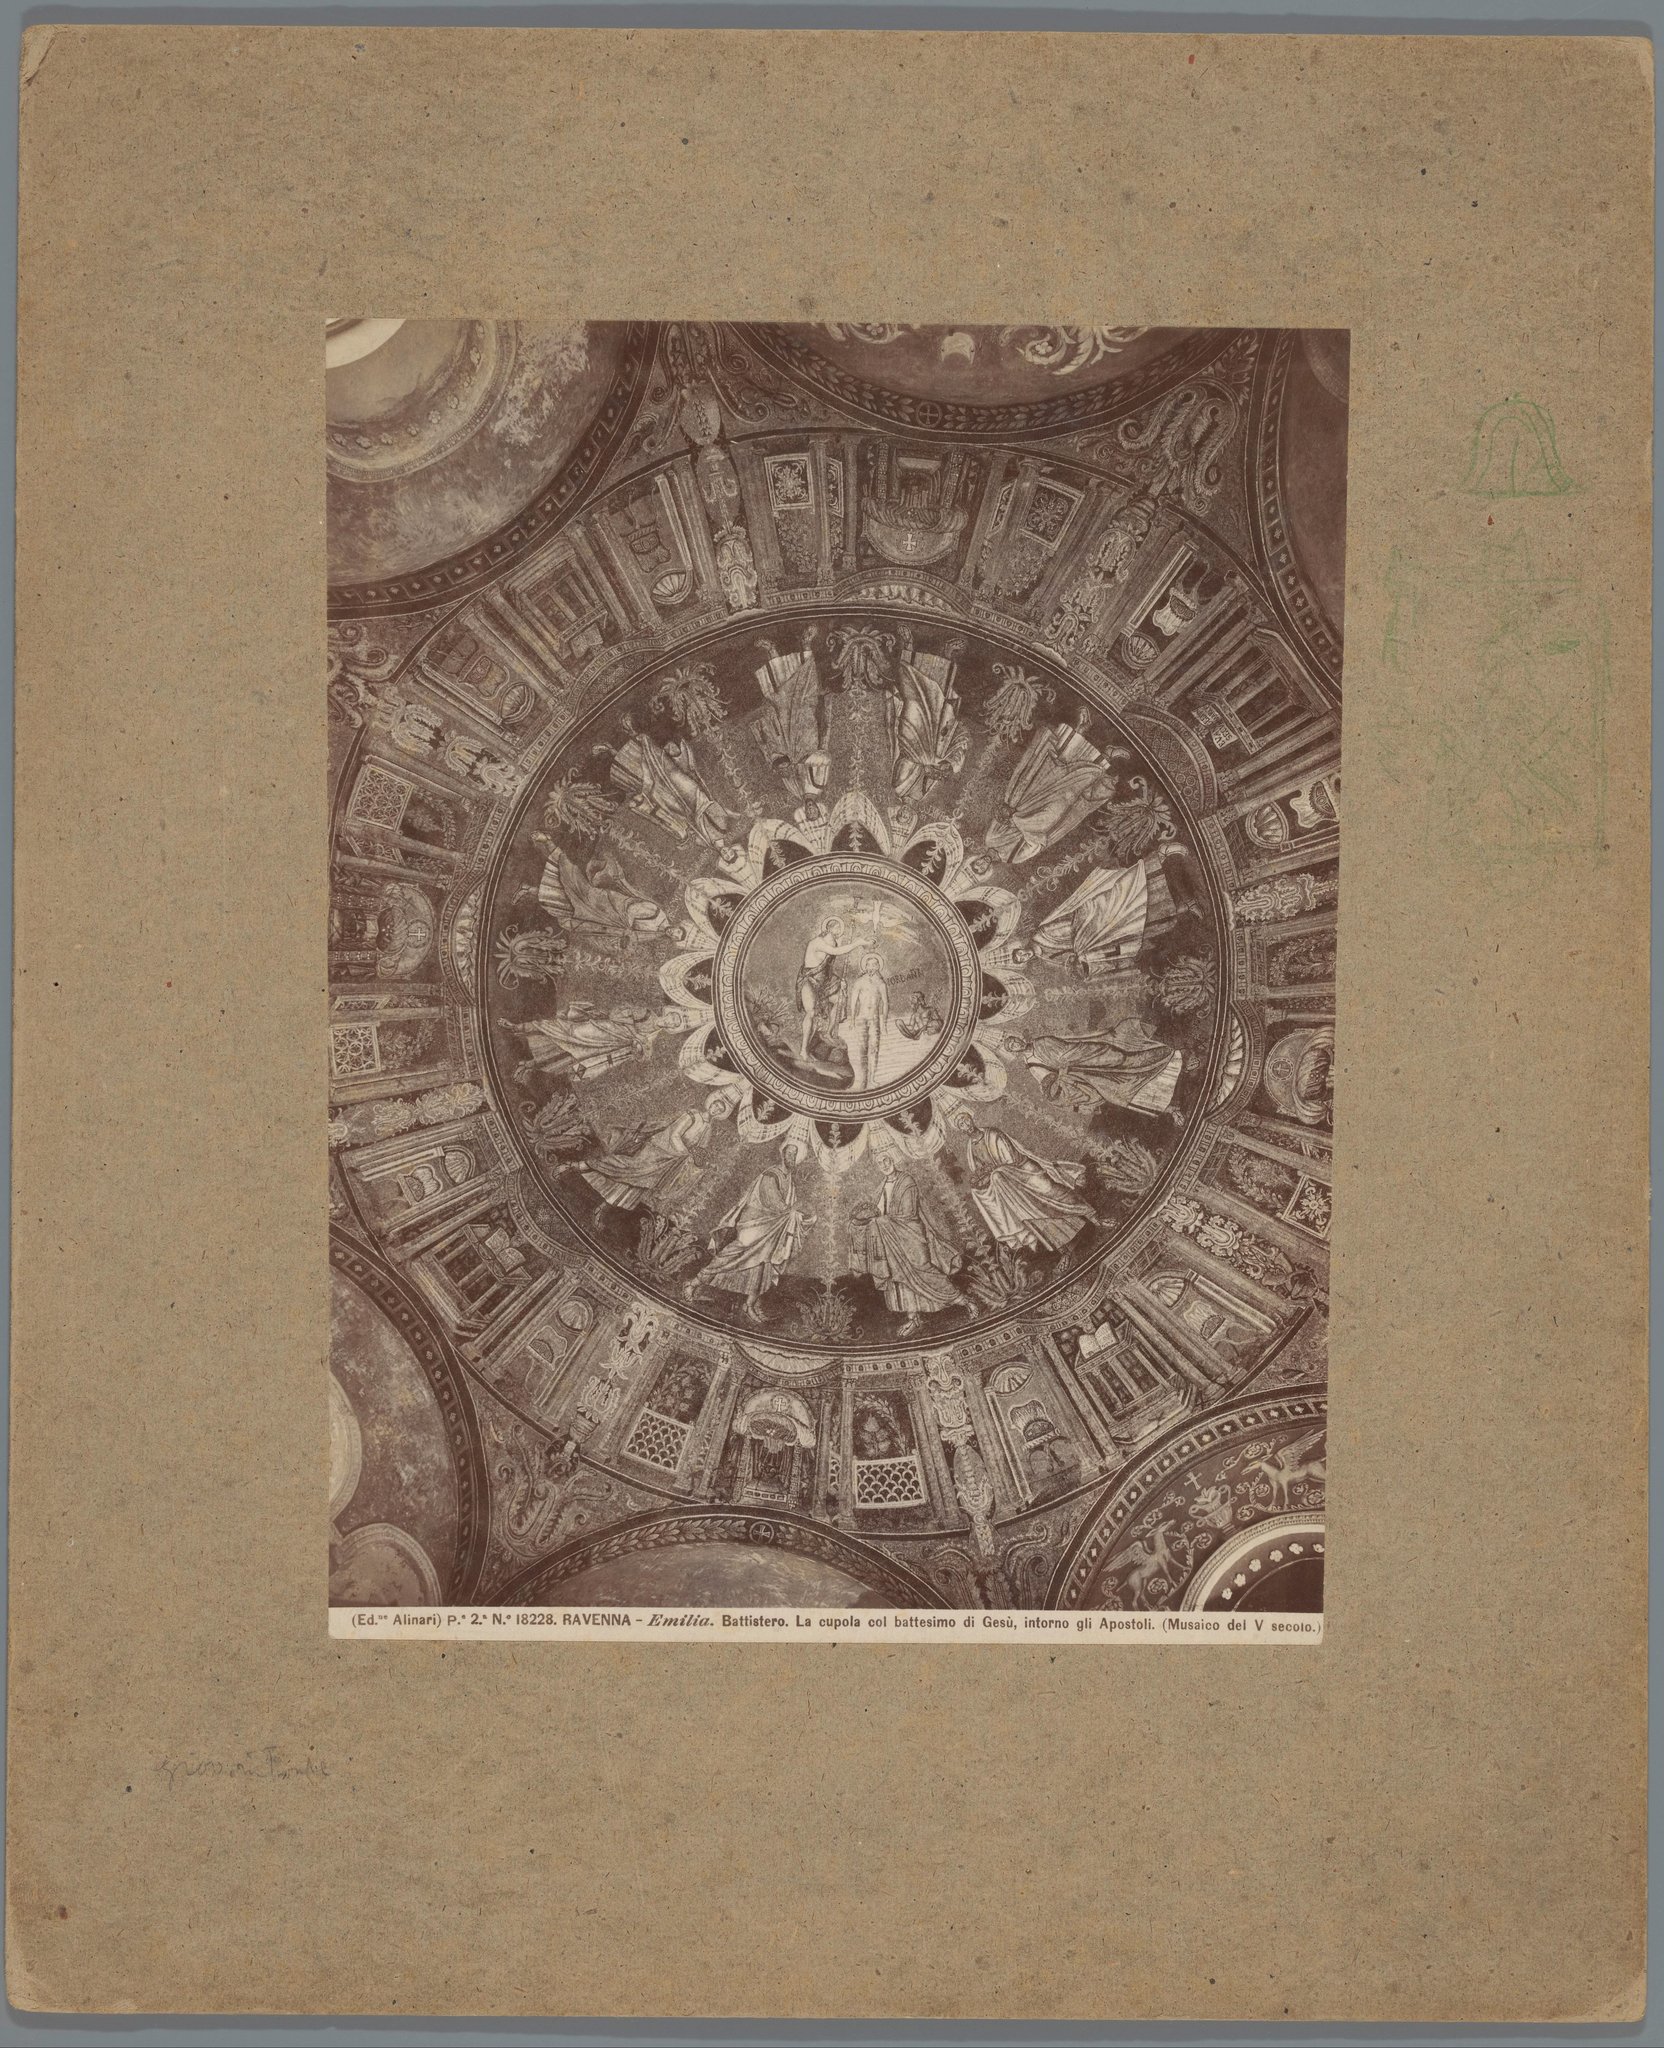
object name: photograph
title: Mozaïek in de koepel van het Baptisterium van de orthodoxen te Ravenna, voorstellende de doop van Christus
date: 1875-1900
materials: cardboard, photographic support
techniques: albumen print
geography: baptisterium van de orthodoxen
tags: baptism of christ in the river jordan: john the baptist pouring out water on christ's head: the holy ghost descends, art (+ mosaic making)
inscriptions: number: ‘P.e 2.a N.o 18228.’, collector's mark: Lugt 3937